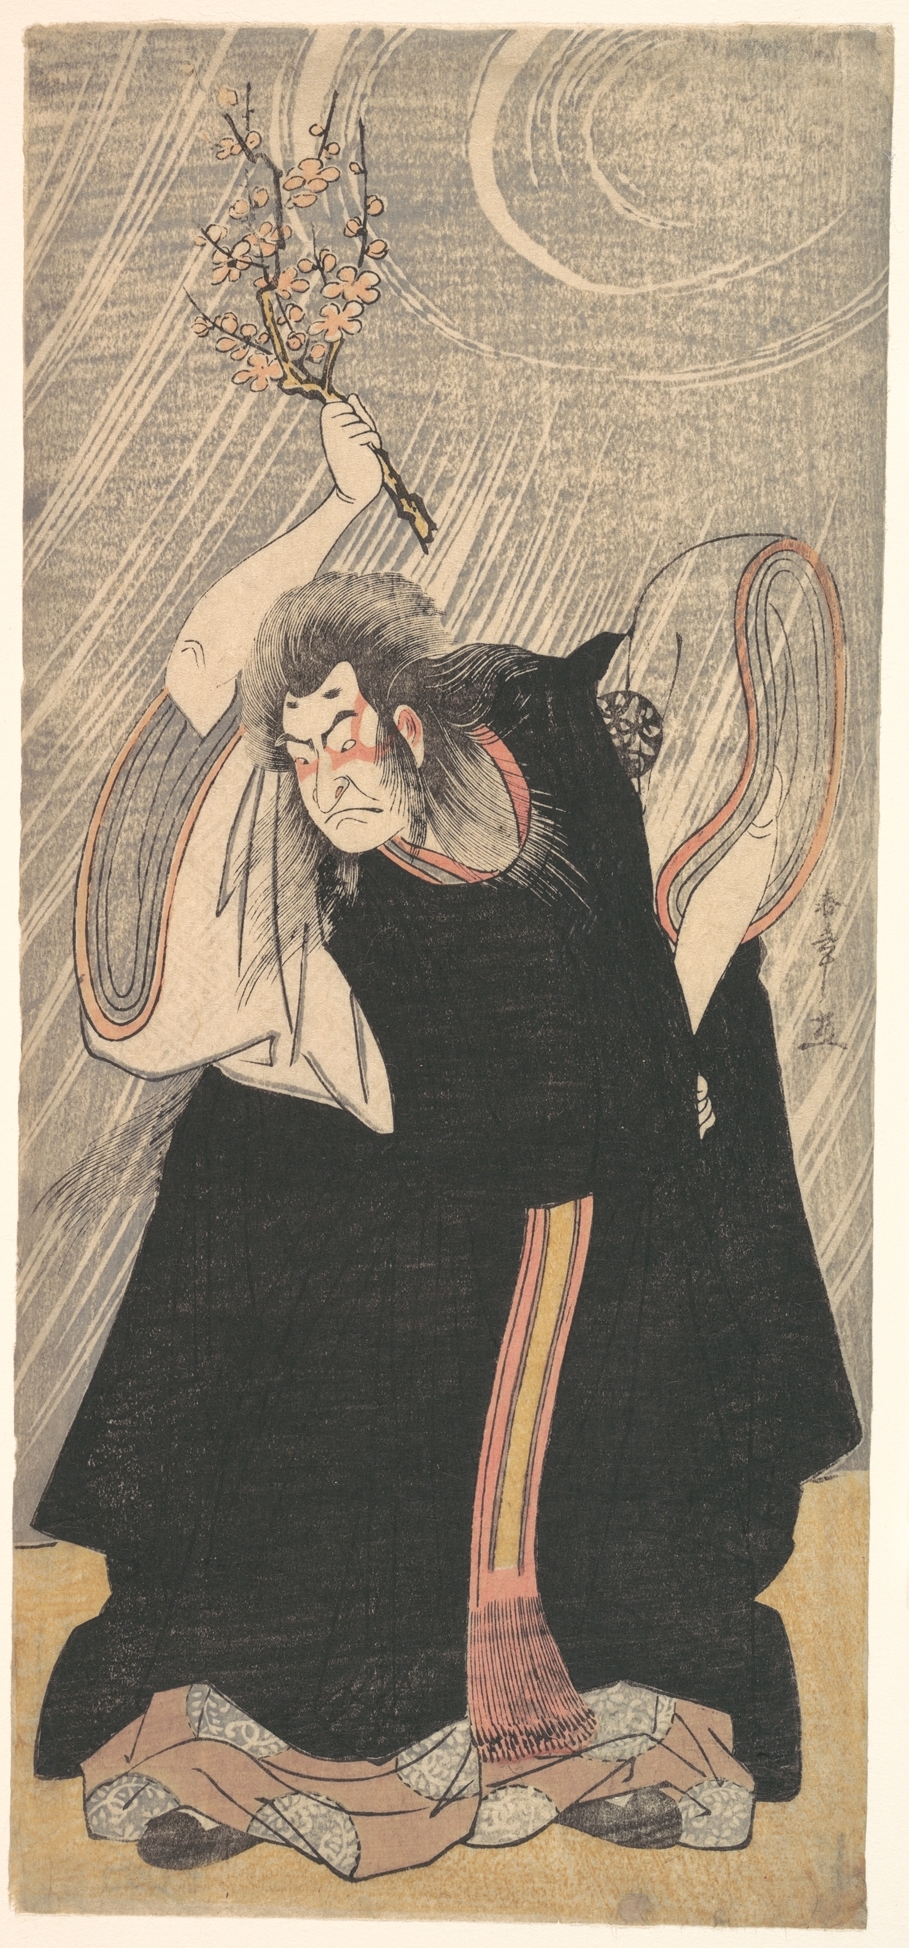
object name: woodblock print nishiki e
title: The Actor Nakamura Nakazō in the Role of Kan Shōjō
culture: japanese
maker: katsukawa shunshō 勝川春章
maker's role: artist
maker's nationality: japanese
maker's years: 1726-1792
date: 1780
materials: ink, paper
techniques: nishiki e, woodblock print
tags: men,actors